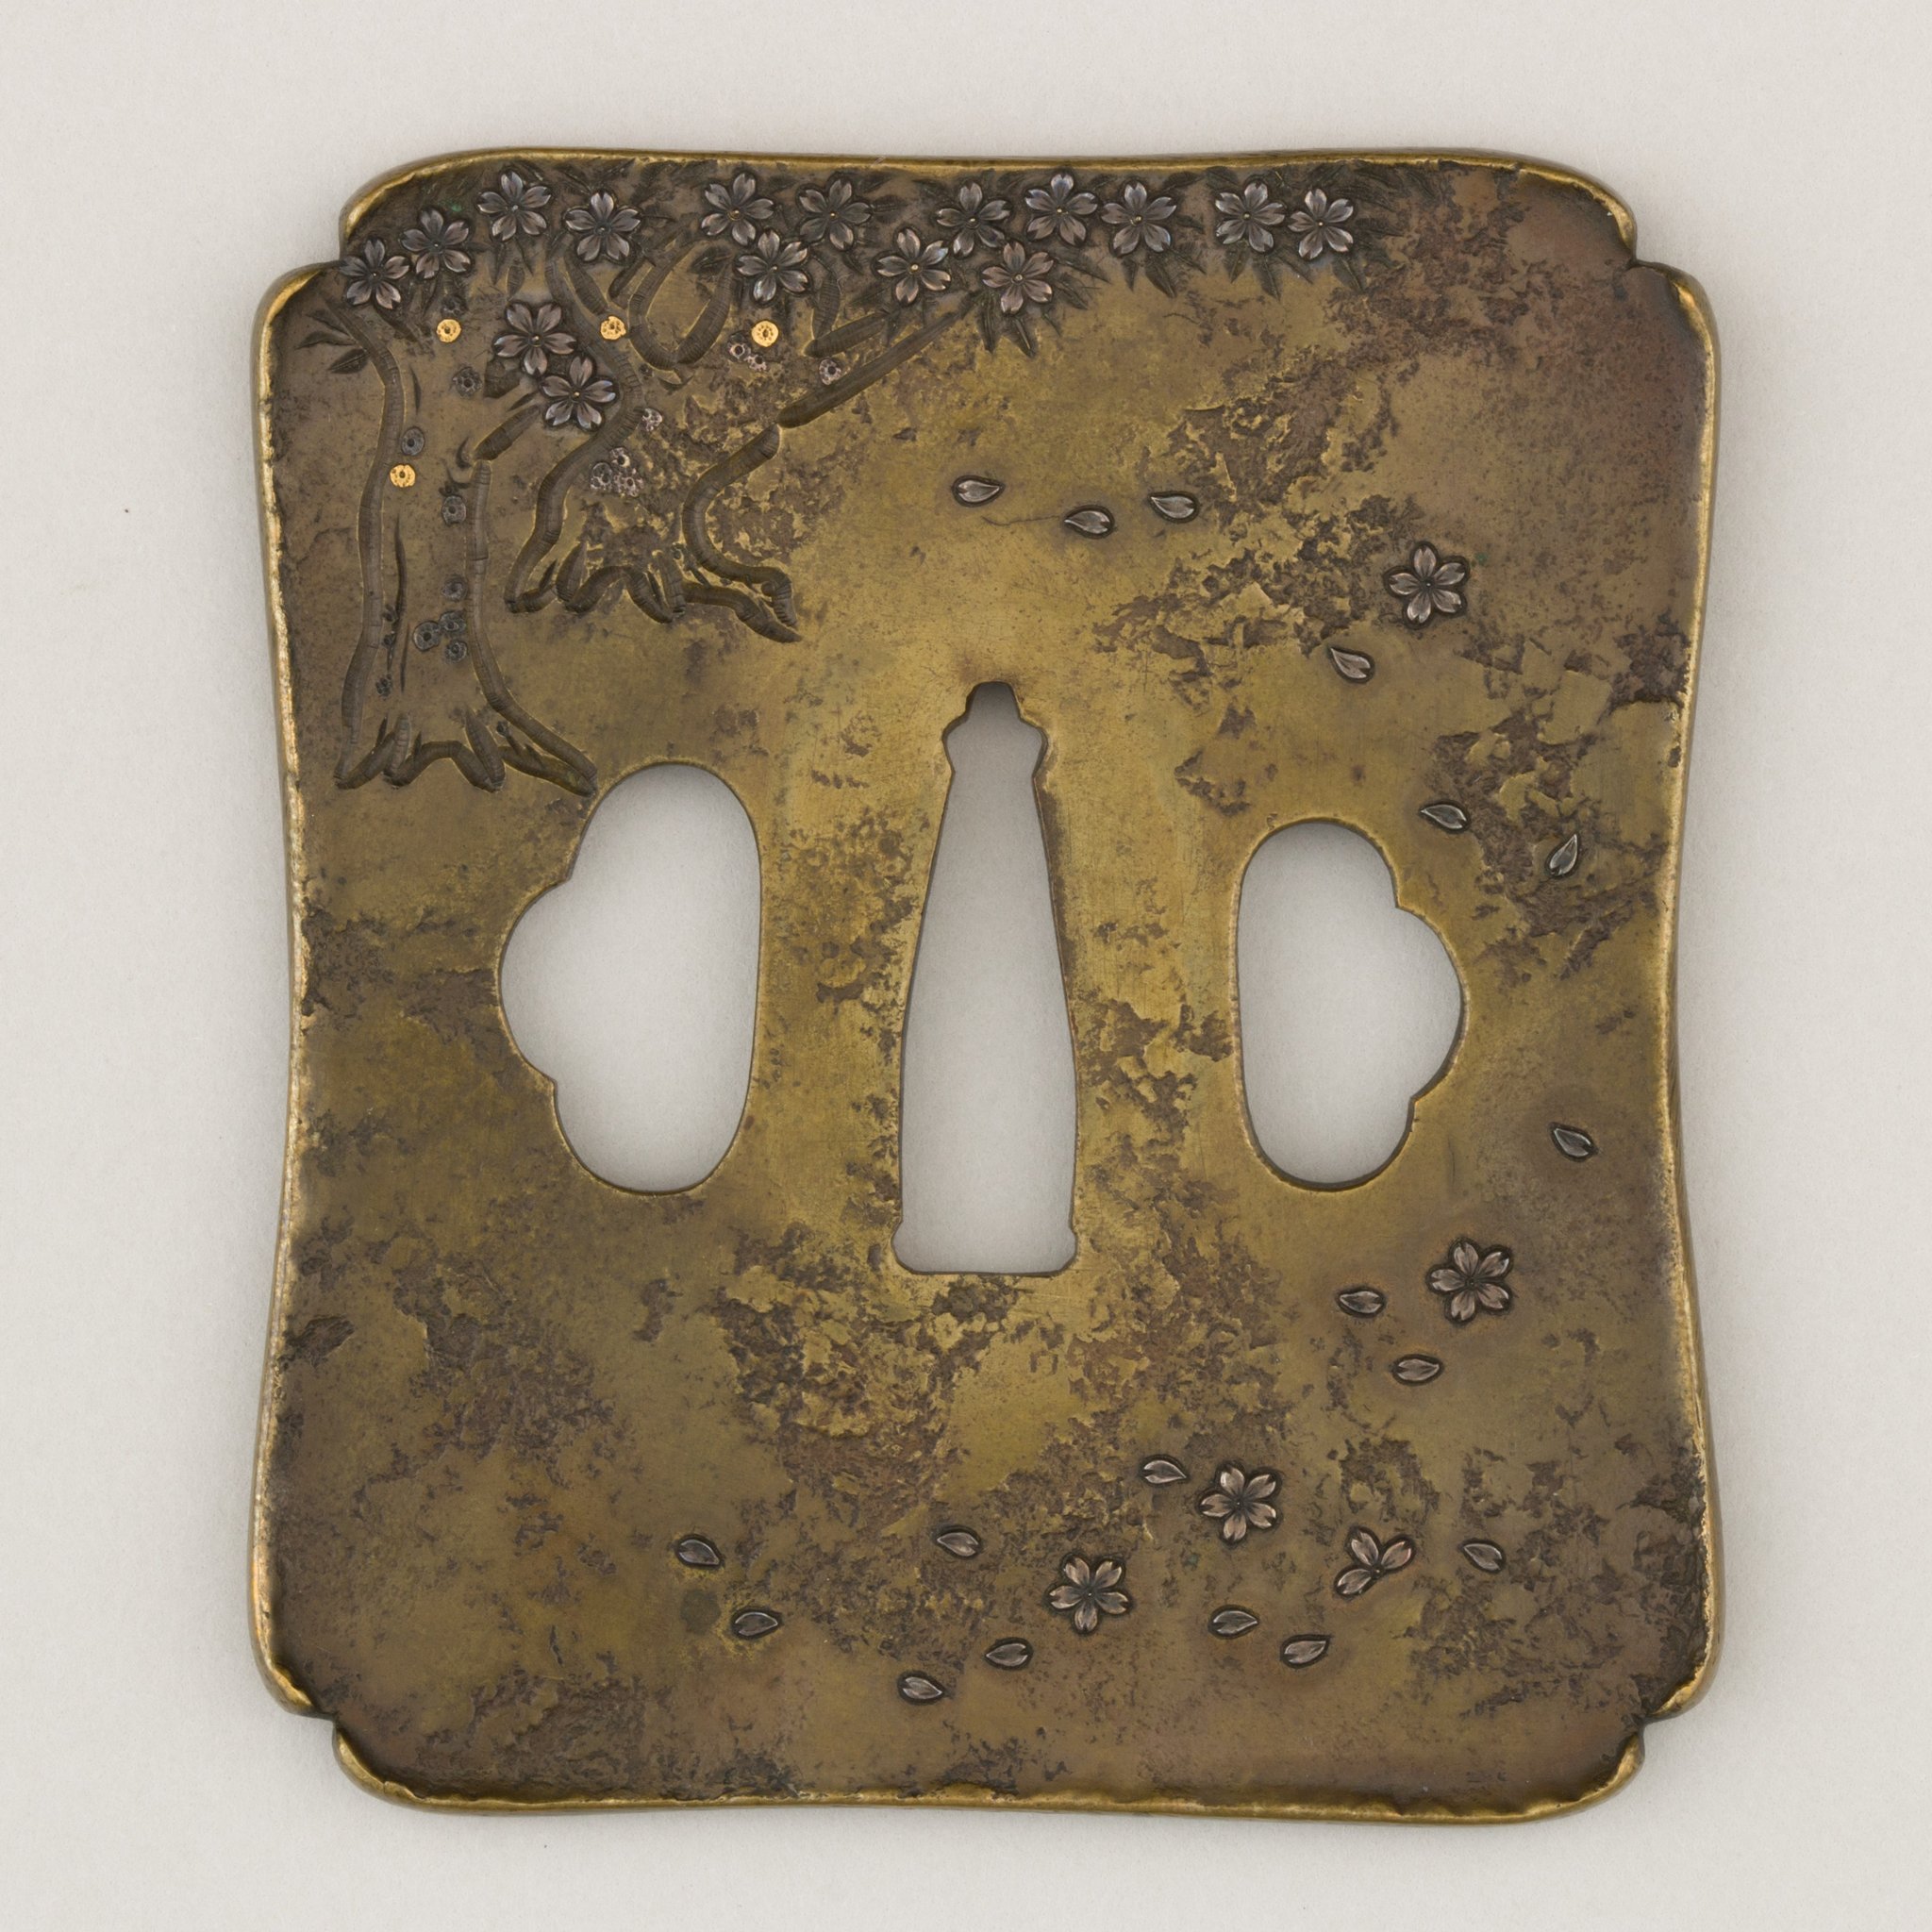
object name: sword guard tsuba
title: Sword Guard (Tsuba)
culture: japanese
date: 1701-1800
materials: copper, copper alloy, gold, silver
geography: japan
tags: trees